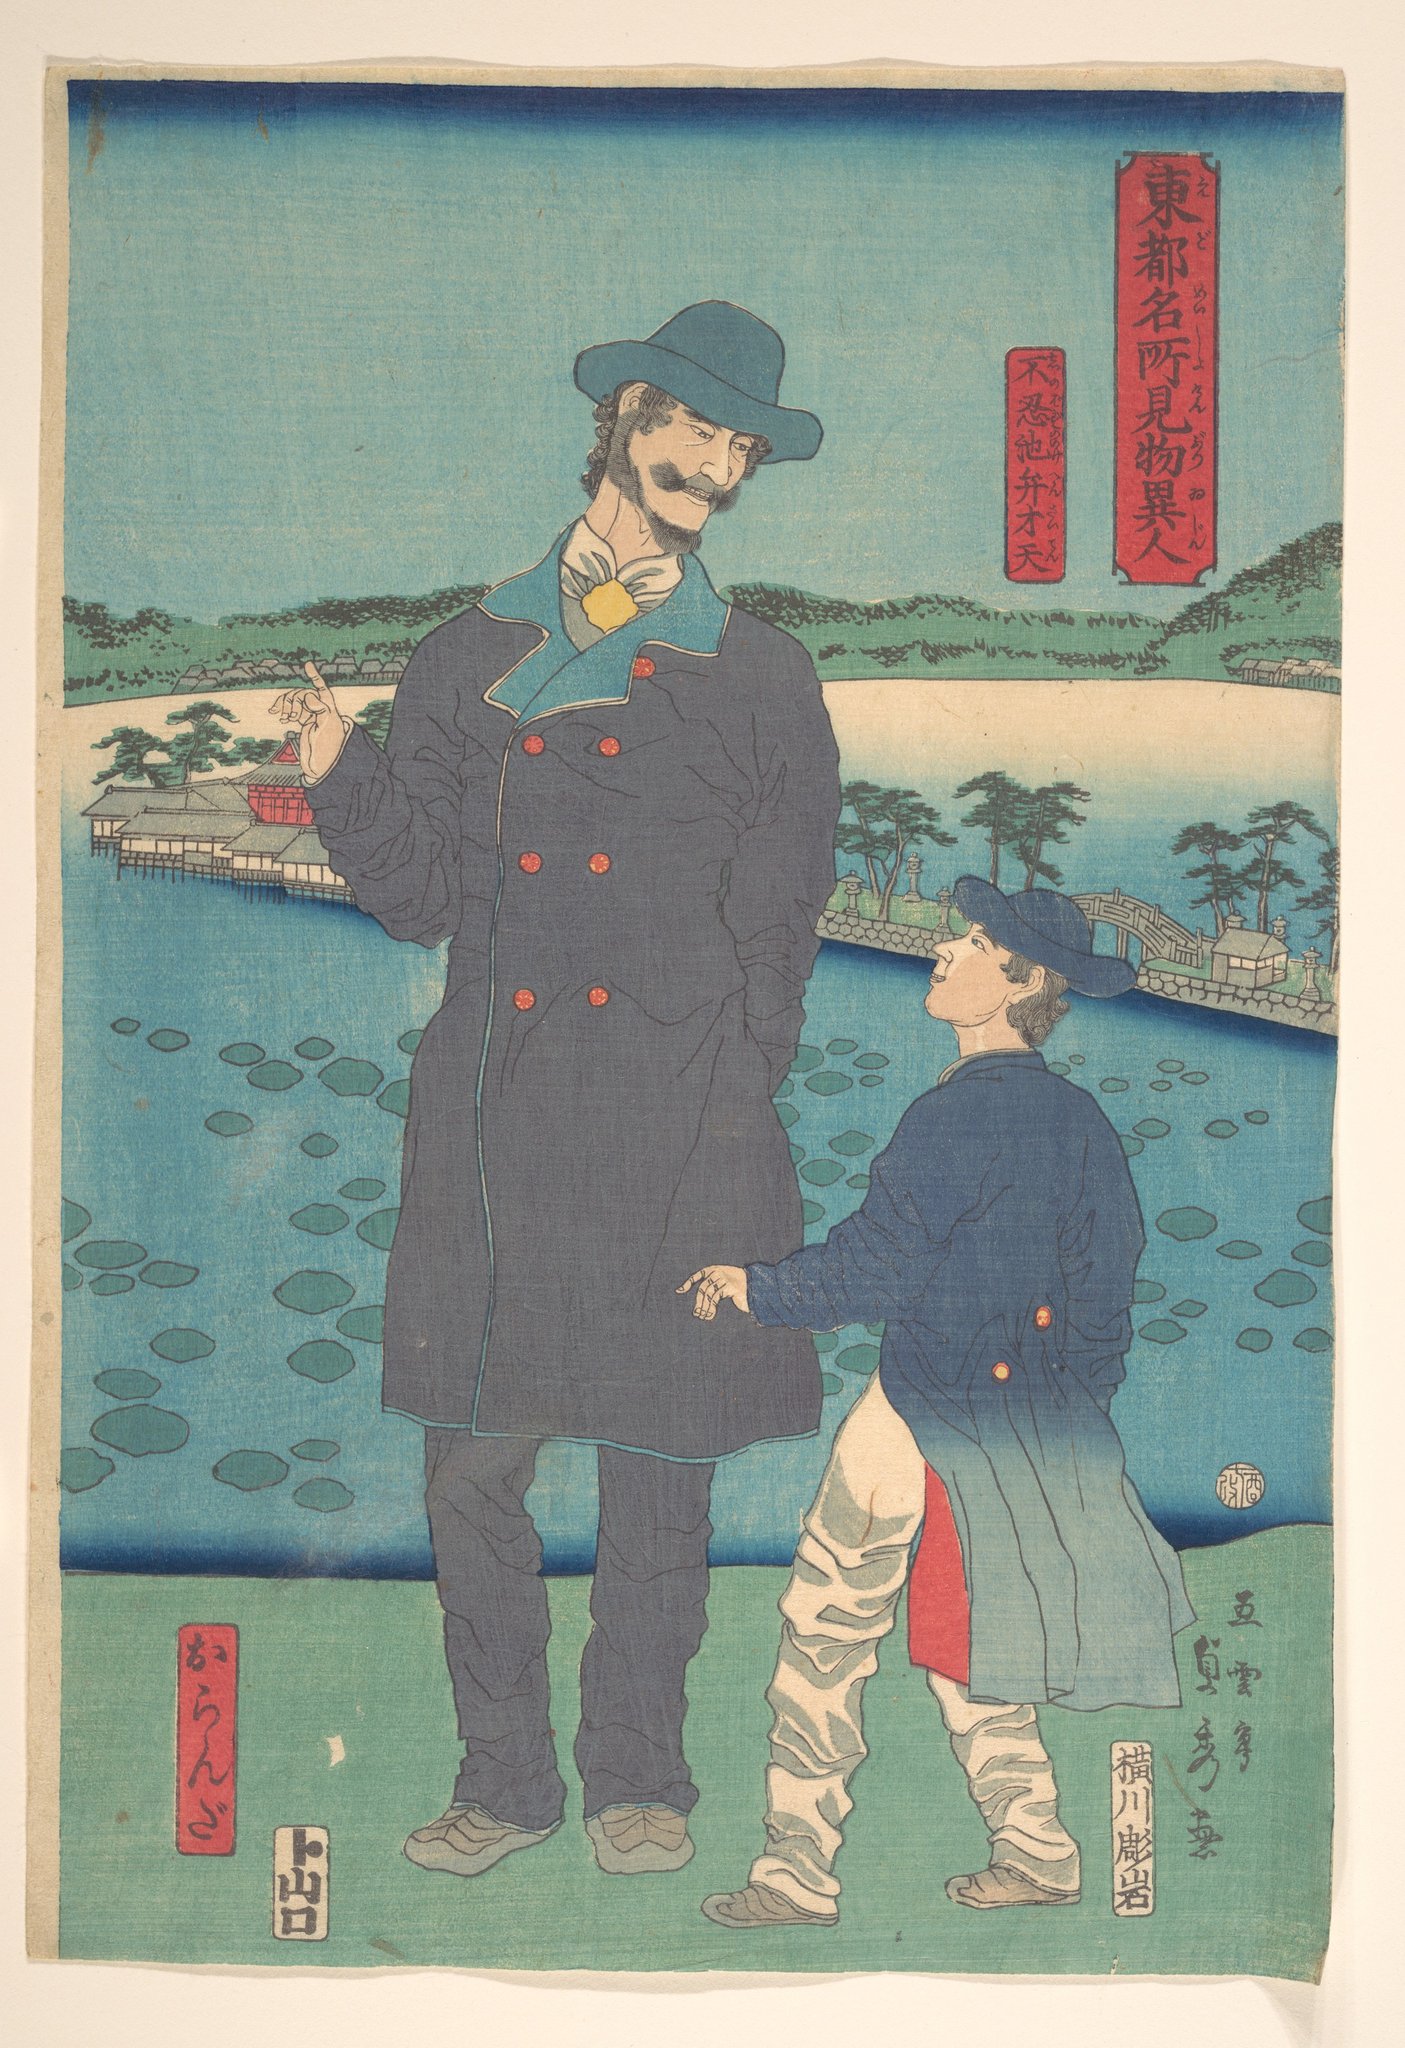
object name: print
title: Dutchman and Child Viewing the Benten Shrine at Shinobazu Pond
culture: japanese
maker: utagawa (gountei) sadahide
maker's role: artist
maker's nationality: japanese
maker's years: 1807-1873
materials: ink, paper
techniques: woodblock print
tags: boys,men,ponds